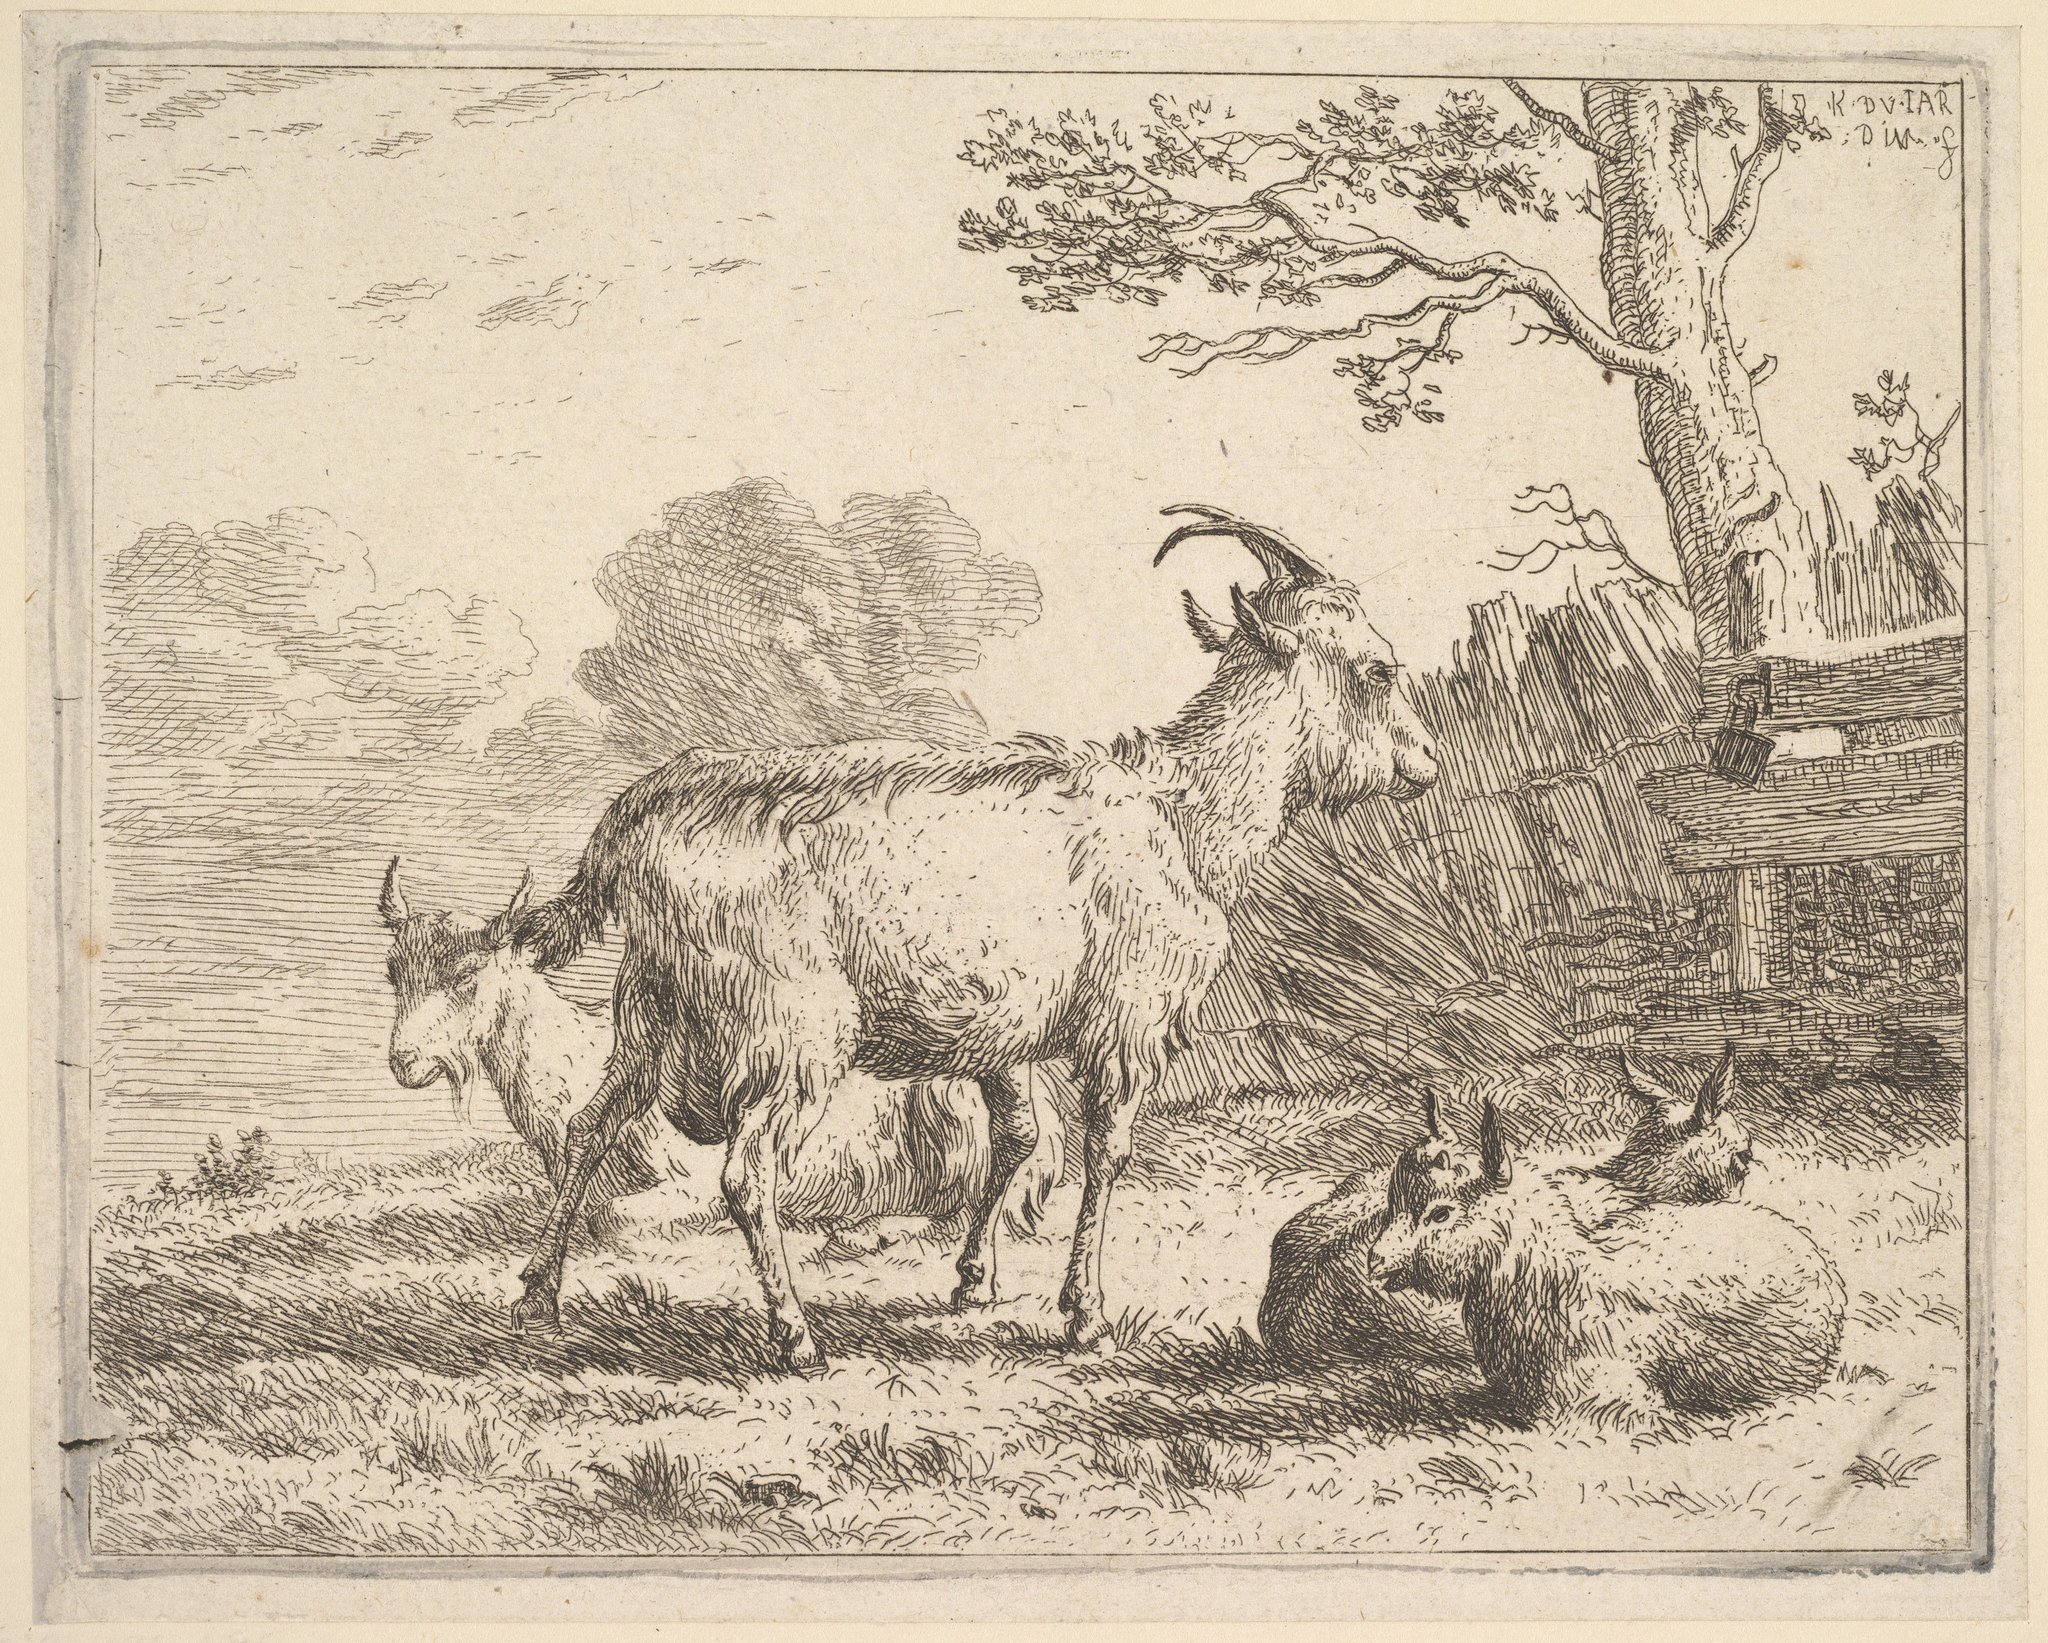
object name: print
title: Four goats; at the back a nanny goat lies on the ground, in the middle a billy goat stands, in the front two kids lie on the ground, a fence and tree beyond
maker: karel dujardin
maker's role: artist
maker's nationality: dutch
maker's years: 1622-1678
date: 1641-1678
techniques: etching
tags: goats